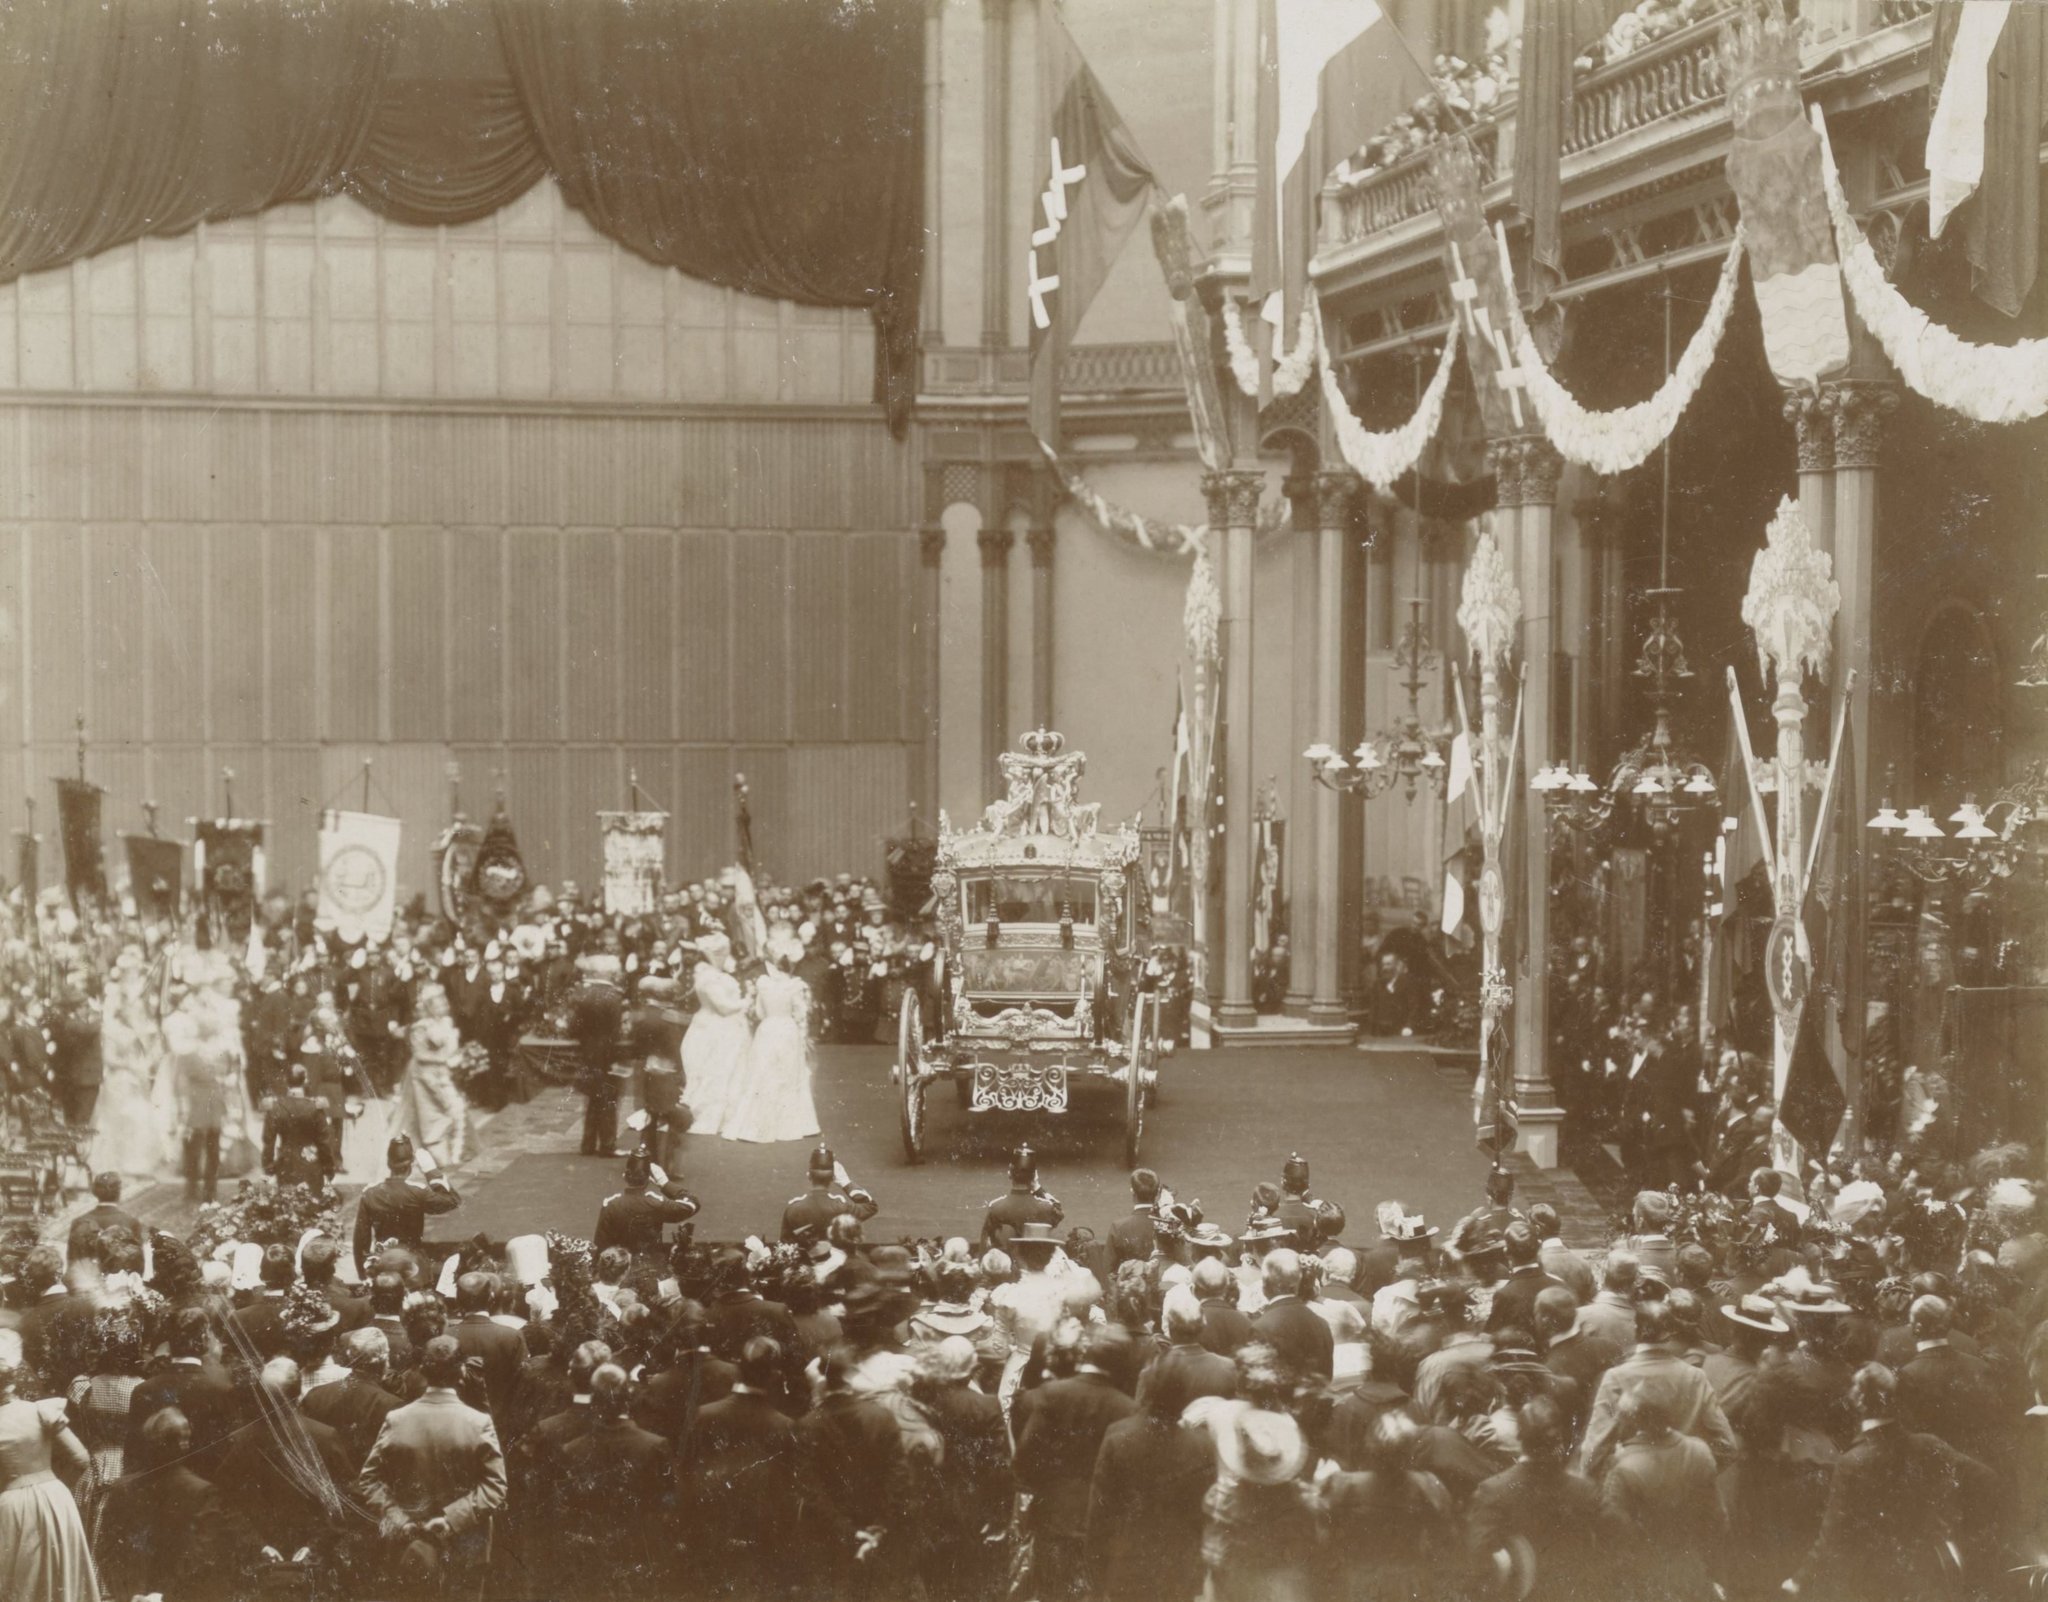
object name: photograph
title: In ontvangst nemen van de Gouden Koets door koningin Wilhelmina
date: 1898-1910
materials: cardboard, paper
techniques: albumen print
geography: amsterdam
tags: the hague, wilhelmina of the netherlands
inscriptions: name: ‘Sigling & Lukera Amsterdam Jacob van Campen 96’